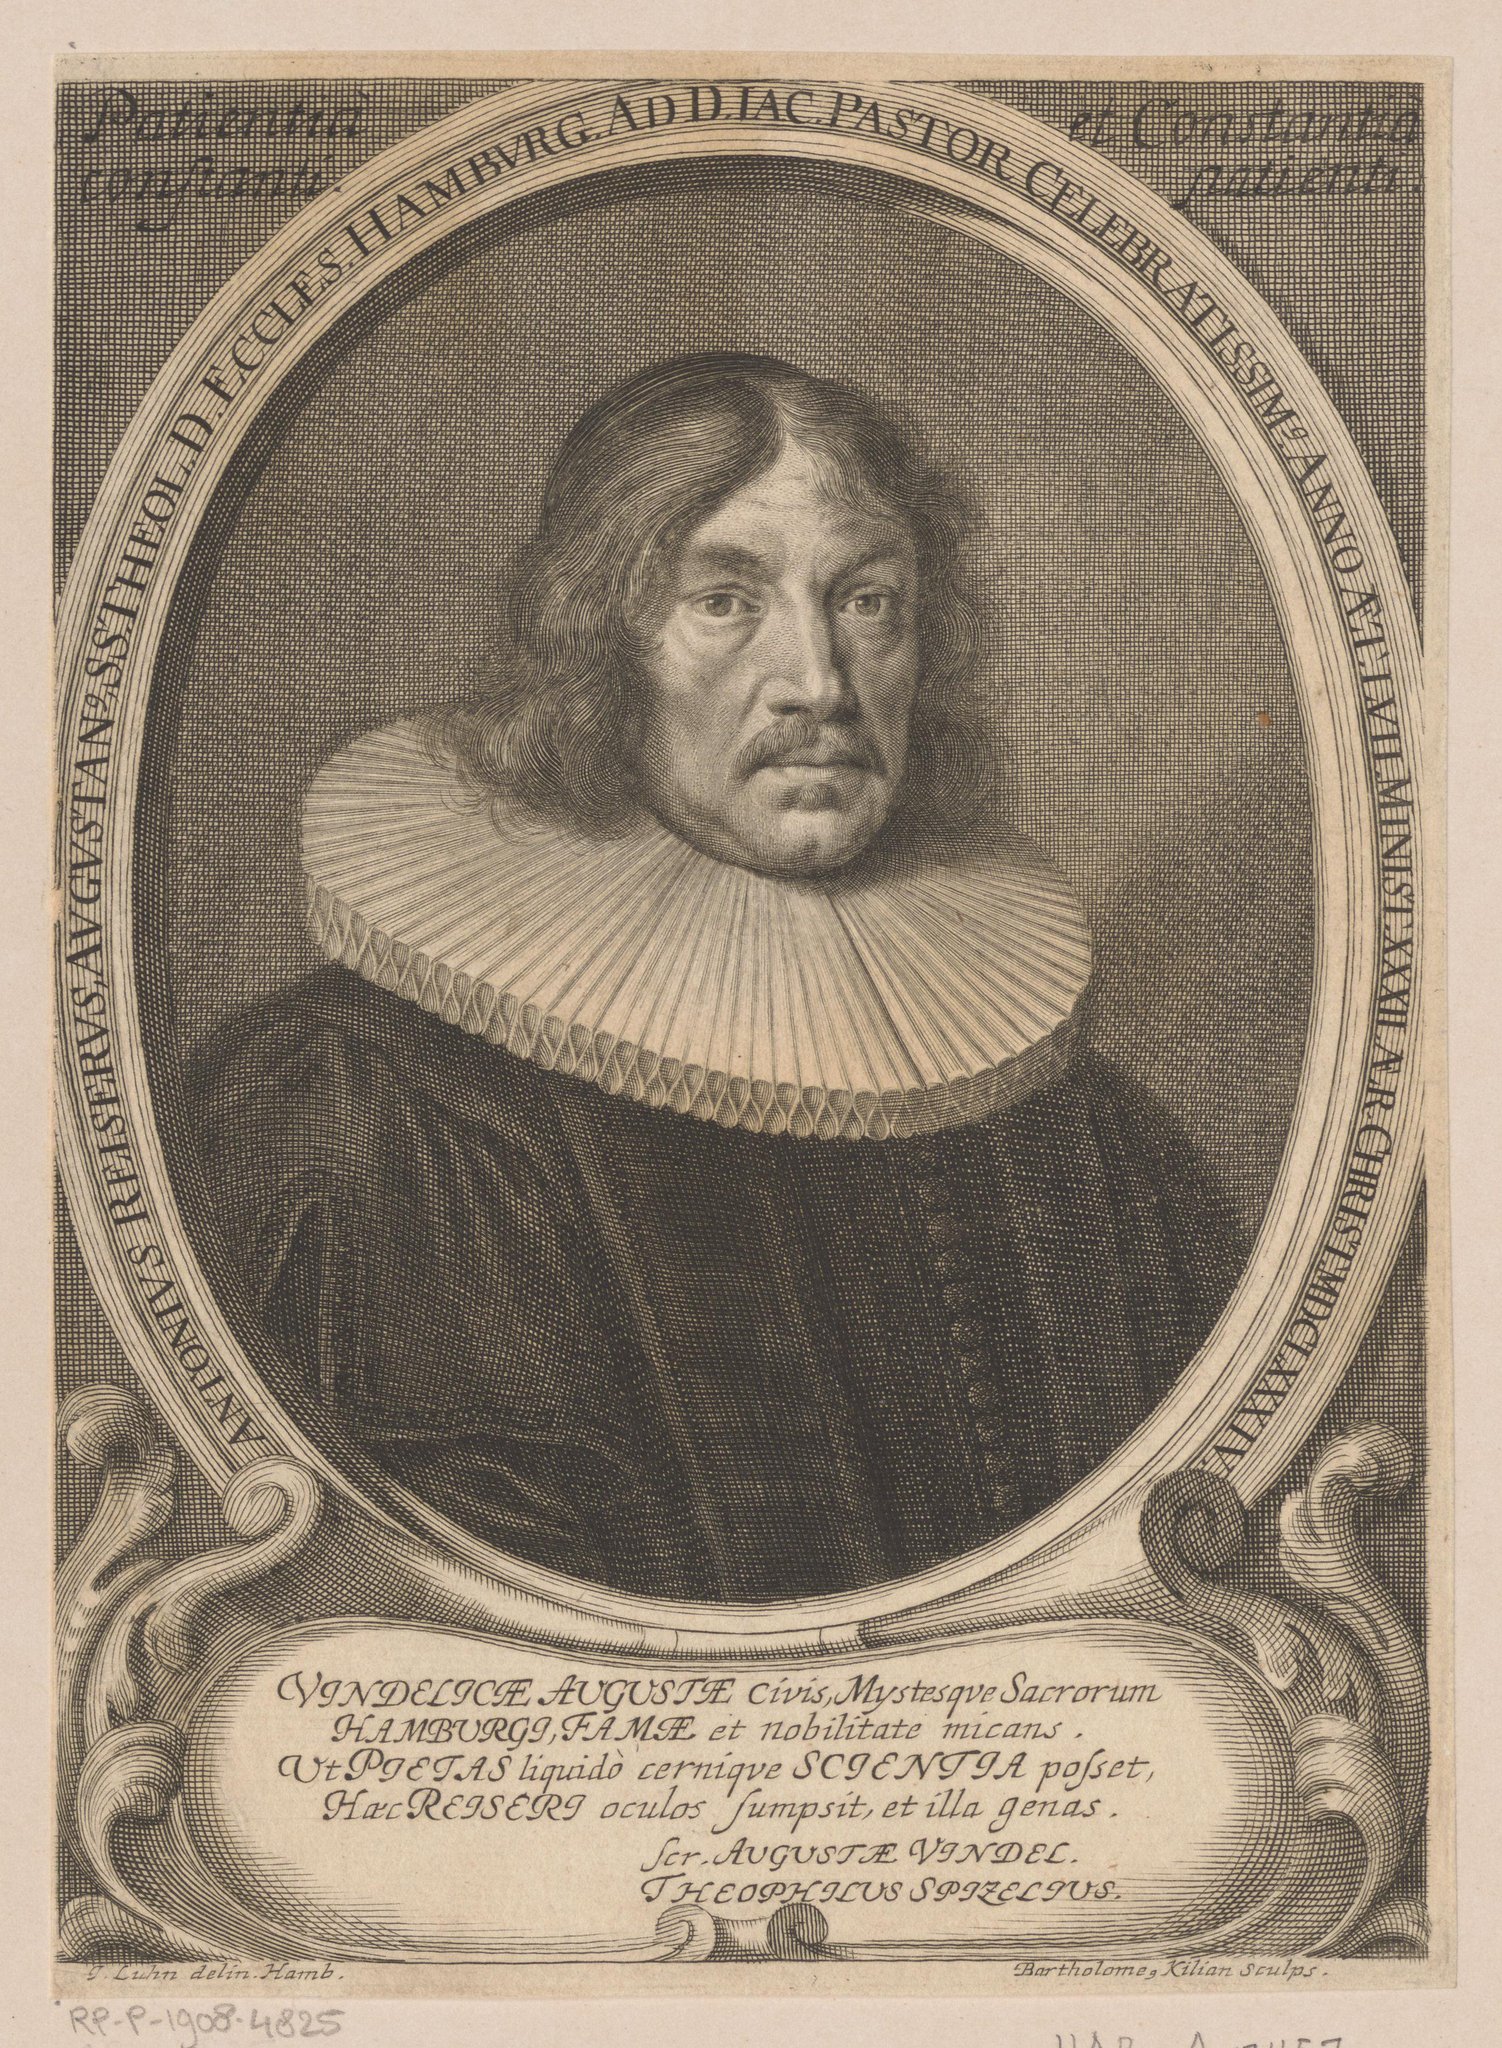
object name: print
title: Portret van Anton Reiser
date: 1684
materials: paper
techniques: engraving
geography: hamburg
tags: augsburg, anton reiser, historical persons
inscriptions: watermark, collector's mark: Lugt 2228